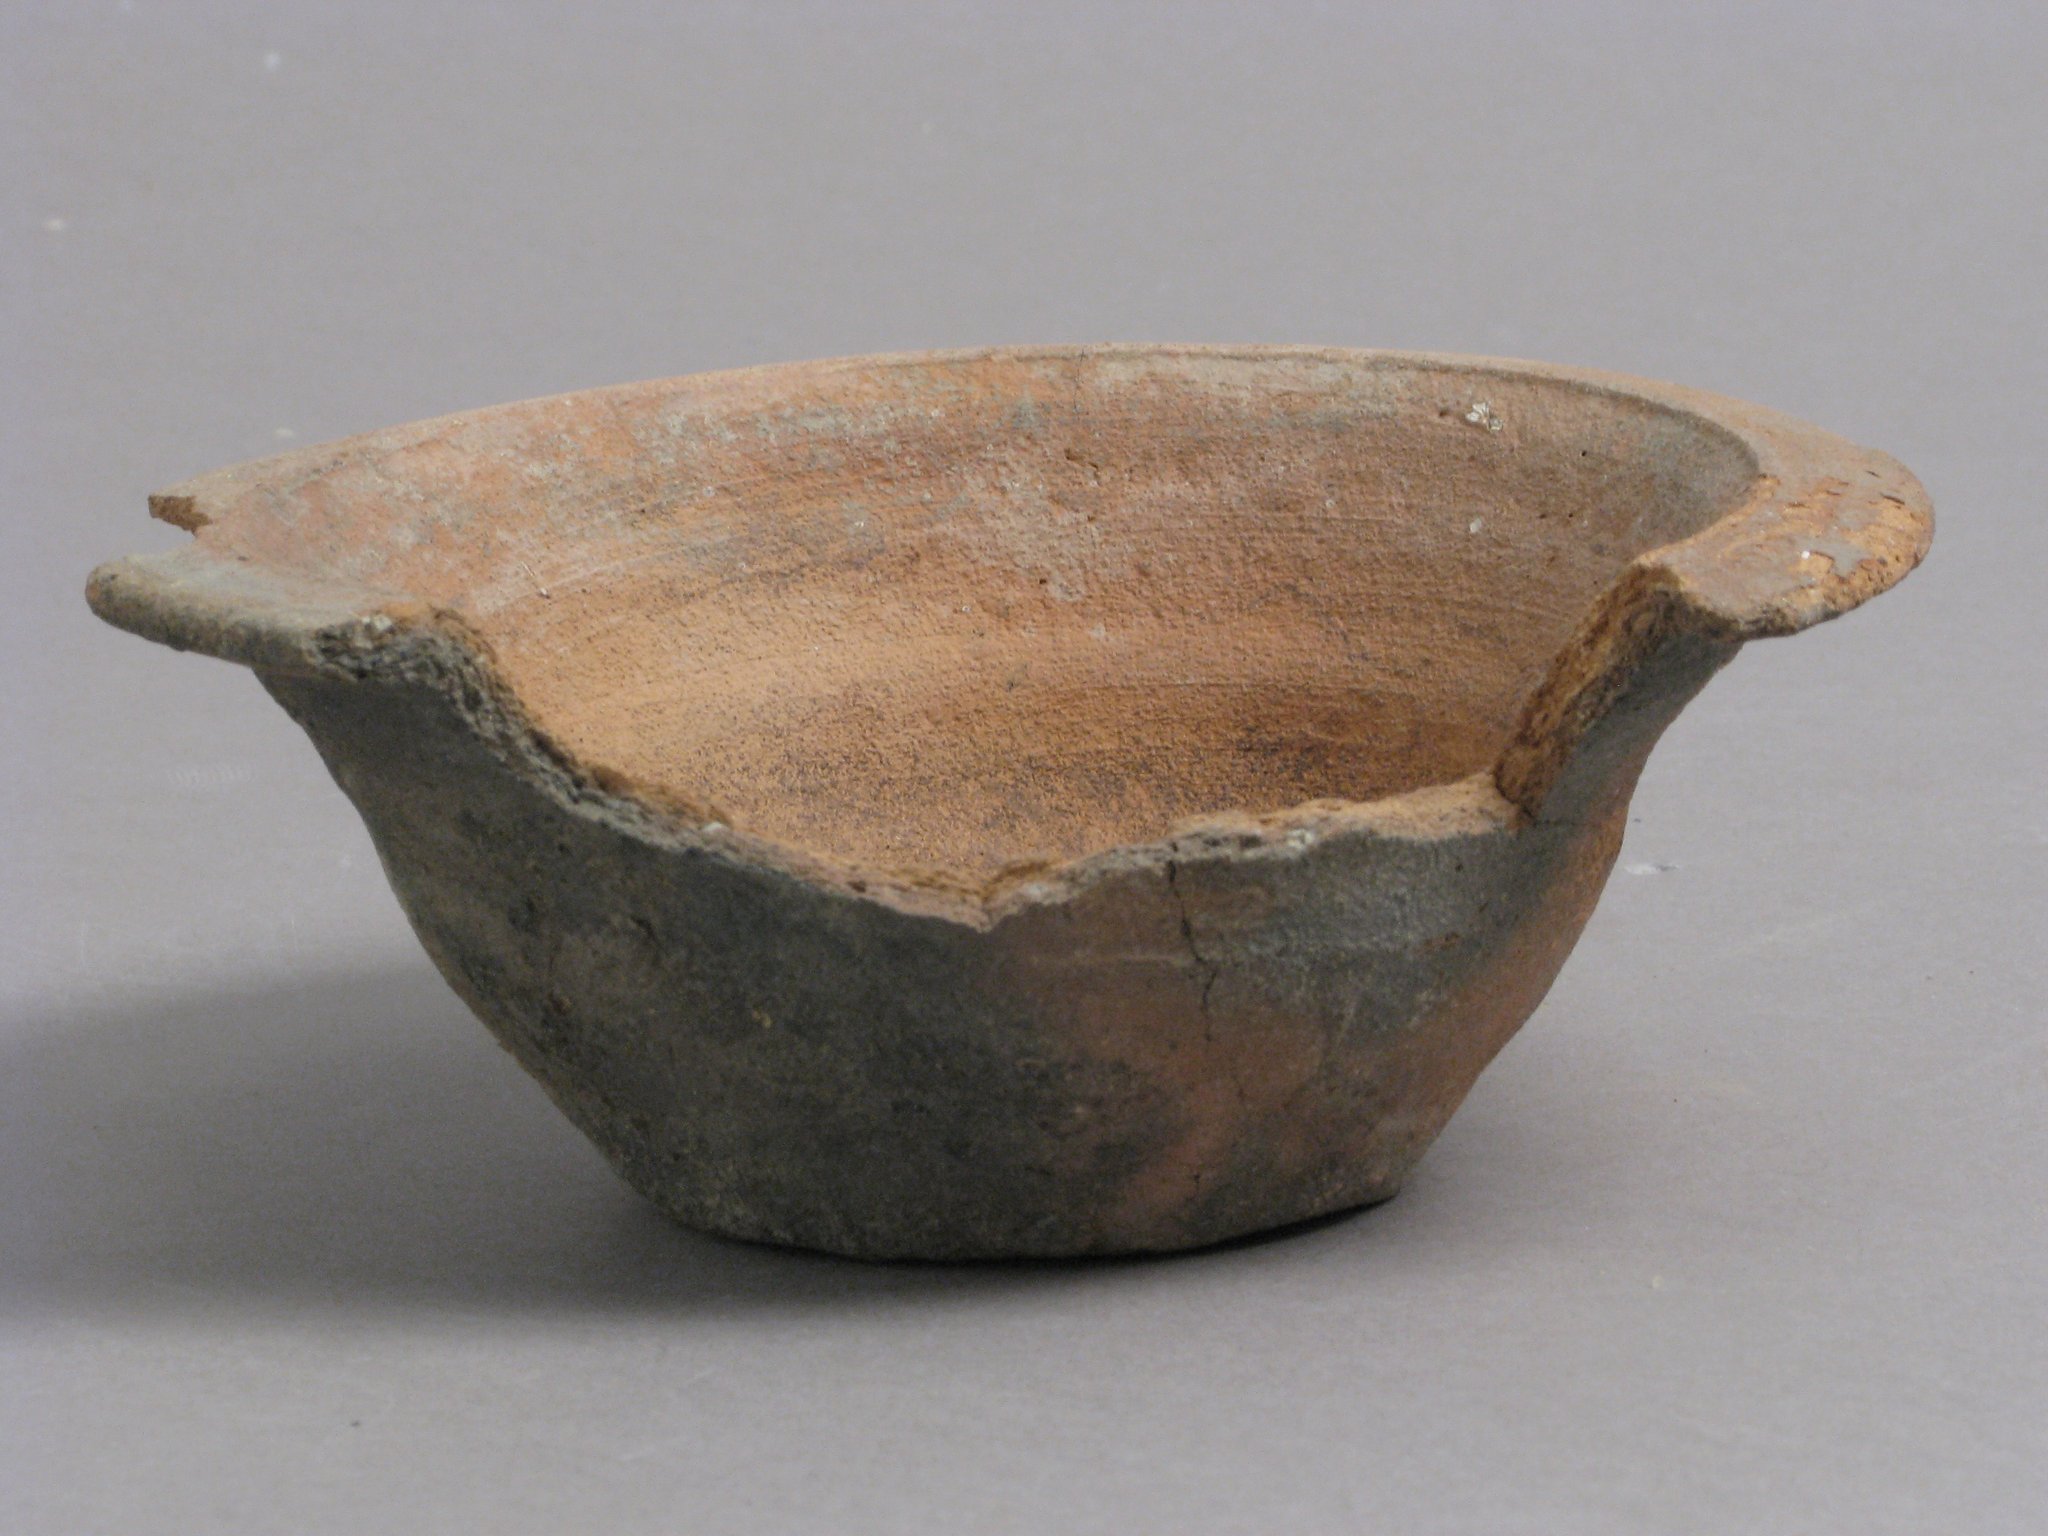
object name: bowl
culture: coptic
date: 301-700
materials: earthenware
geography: egypt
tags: bowls